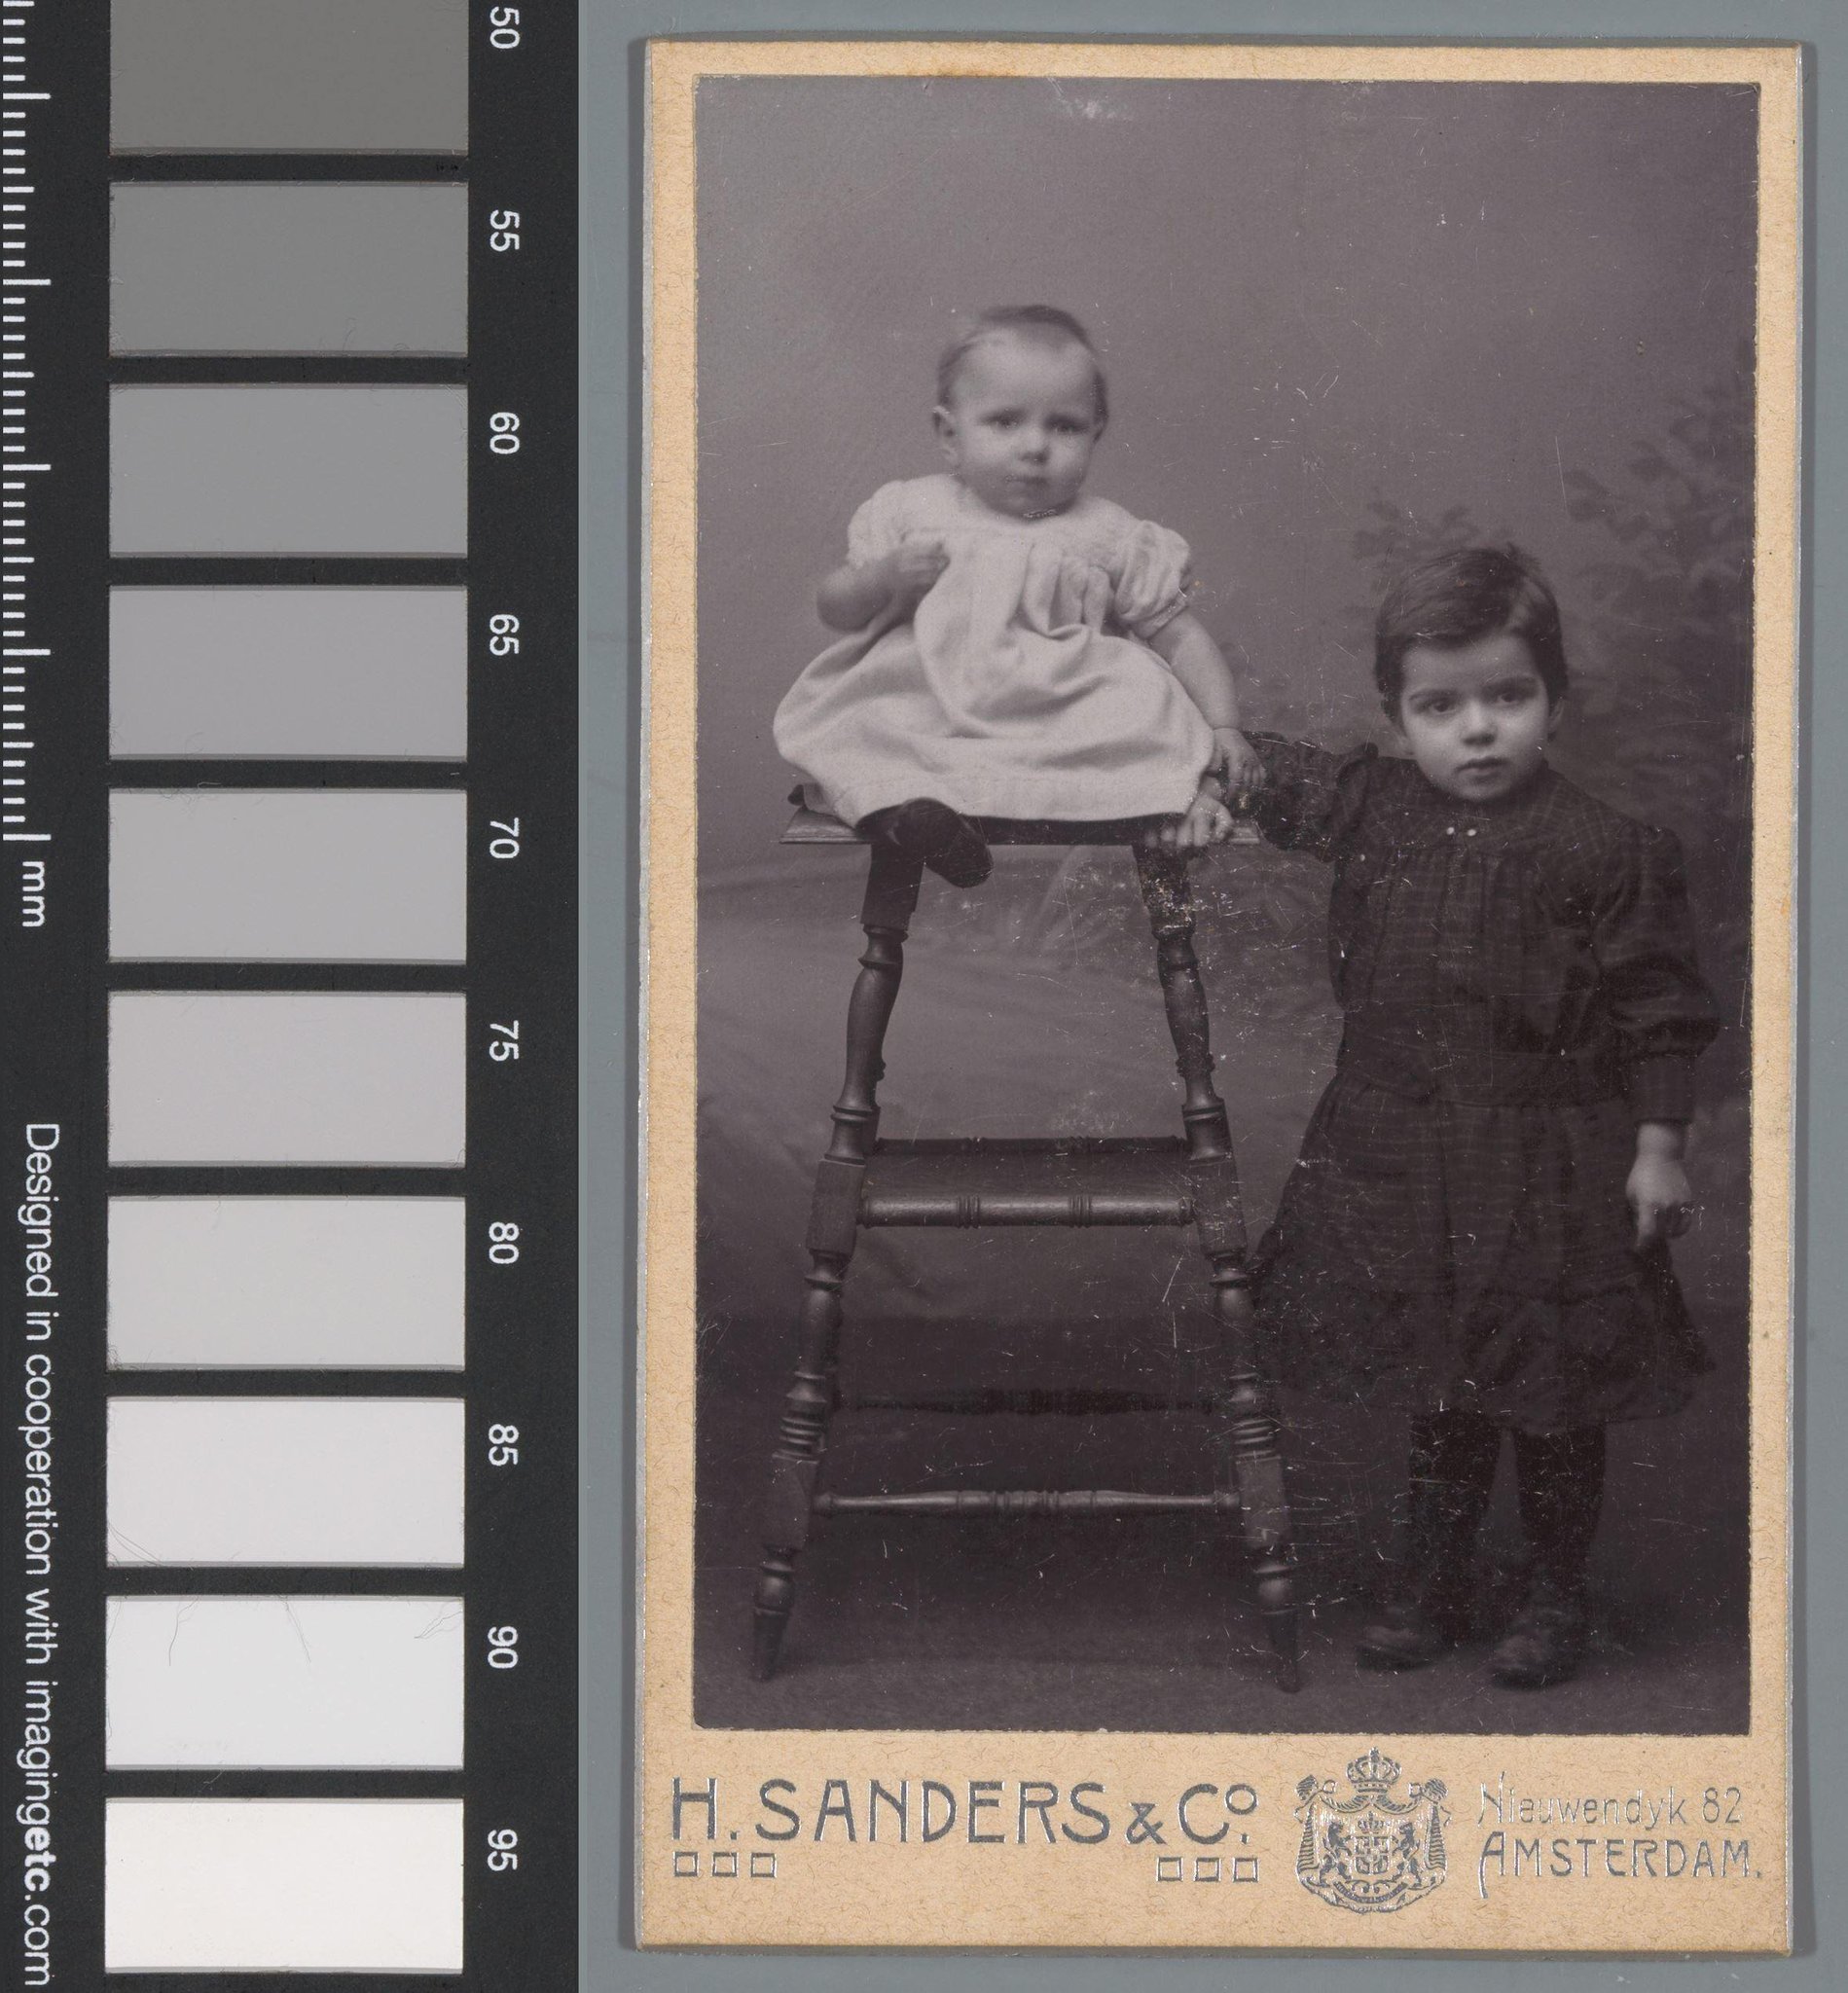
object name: carte de visite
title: Portret van twee onbekende kinderen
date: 1902-1906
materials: cardboard, photographic support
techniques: collodion silver print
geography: amsterdam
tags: historical persons, stool, child (+ two persons)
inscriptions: address: ‘H. SANDERS & Co./ Nieuwendijk 82/ AMSTERDAM.’